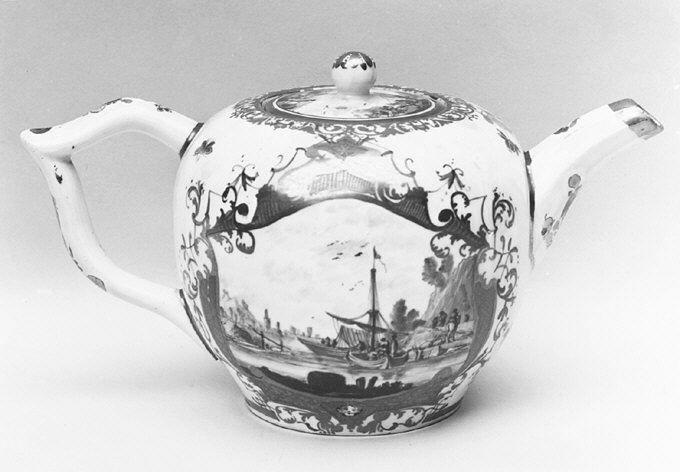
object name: teapot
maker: meissen manufactory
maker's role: manufactory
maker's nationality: german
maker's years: 1710-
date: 1735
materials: hard paste porcelain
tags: human figures,boats